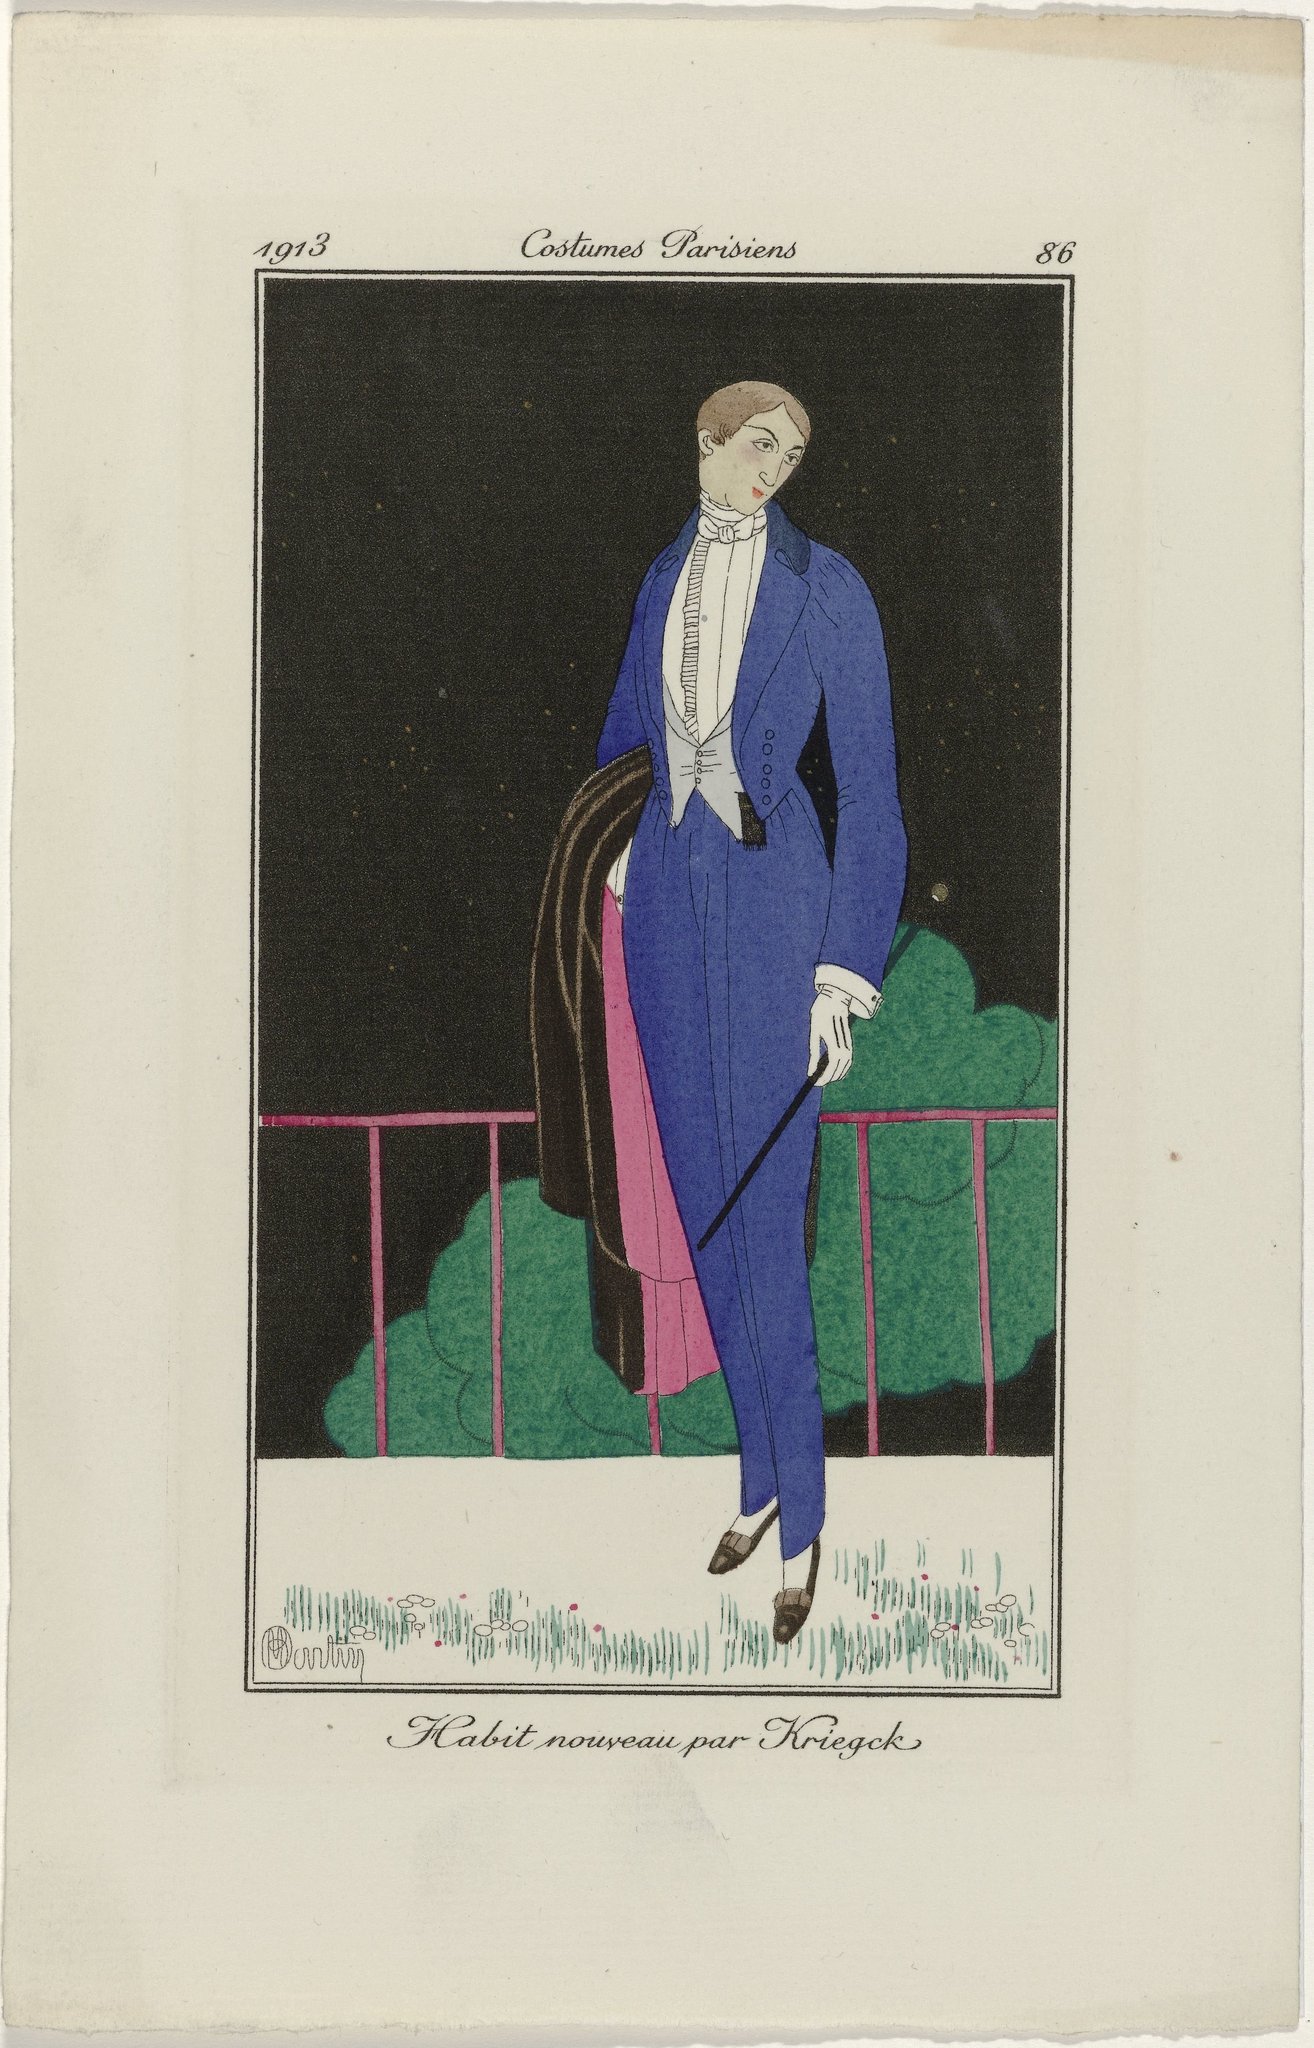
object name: fashion print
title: Journal des Dames et des Modes: the Fashion Illustrators Journal des Dames et des Modes: Fashion News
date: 1913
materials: paper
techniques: engraving, hand coloring, pochoir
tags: clothing for the upper part of the body (vest) (+ men's clothes), neck-gear ~ clothing (tie) (+ men's clothes), trousers, breeches (+ men's clothes), coat (+ men's clothes), fashion plates, shoes, sandals (+ men's clothes), clothes, costume (+ men's clothes), walking-stick, staff, cane (+ men's clothes)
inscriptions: title: ‘Costumes Parisiens’, caption: ‘Habit nouveau par Kriegck’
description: The Journal des Dames was inspired by the eponymous fashion magazine from the previous century and, like the earlier publication, referred to its illustrations as Costumes Parisiens. These Costumes Parisiens (184 illustrations in total) were drawn in a new, flat, decorative manner by George Barbier, Jan van Brock, Victor Lhuer and other Parisian artists, each with a signature style. Every issue came with two or three separate plates. These showed a wide variety of fashionable apparel, from elegant evening attire to outdoor outfits. A brief caption provides the name of the garment and the material from which it was made, but never the name of a fashion house.